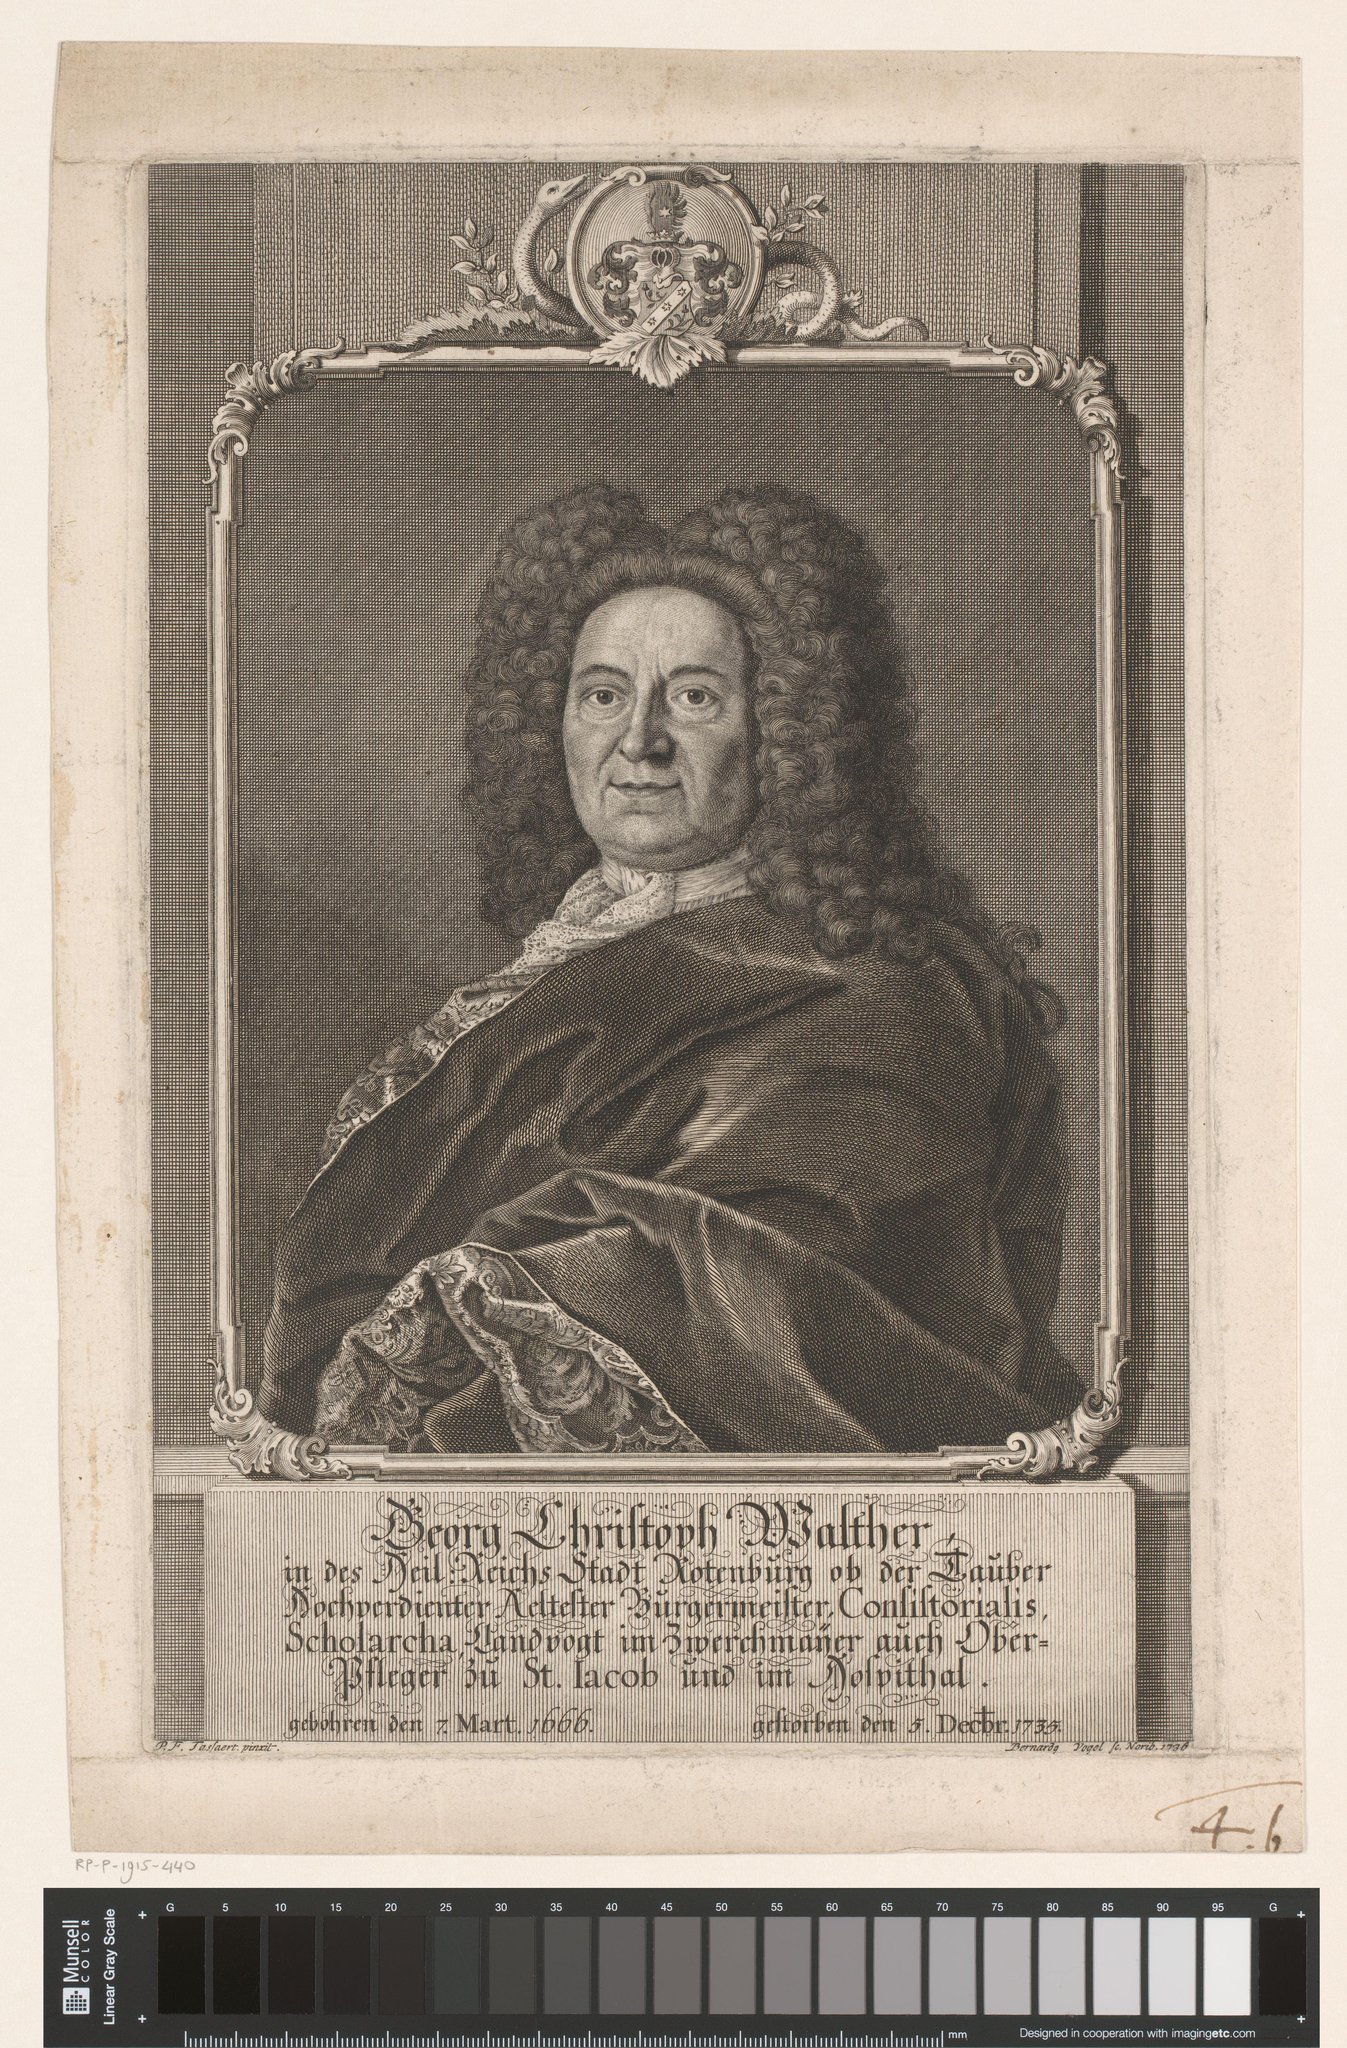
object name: print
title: Portret van Georg Christoph Walther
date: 1736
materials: paper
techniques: engraving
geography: nuremberg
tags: historical persons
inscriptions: collector's mark: Lugt 2228, number: ‘4.6’